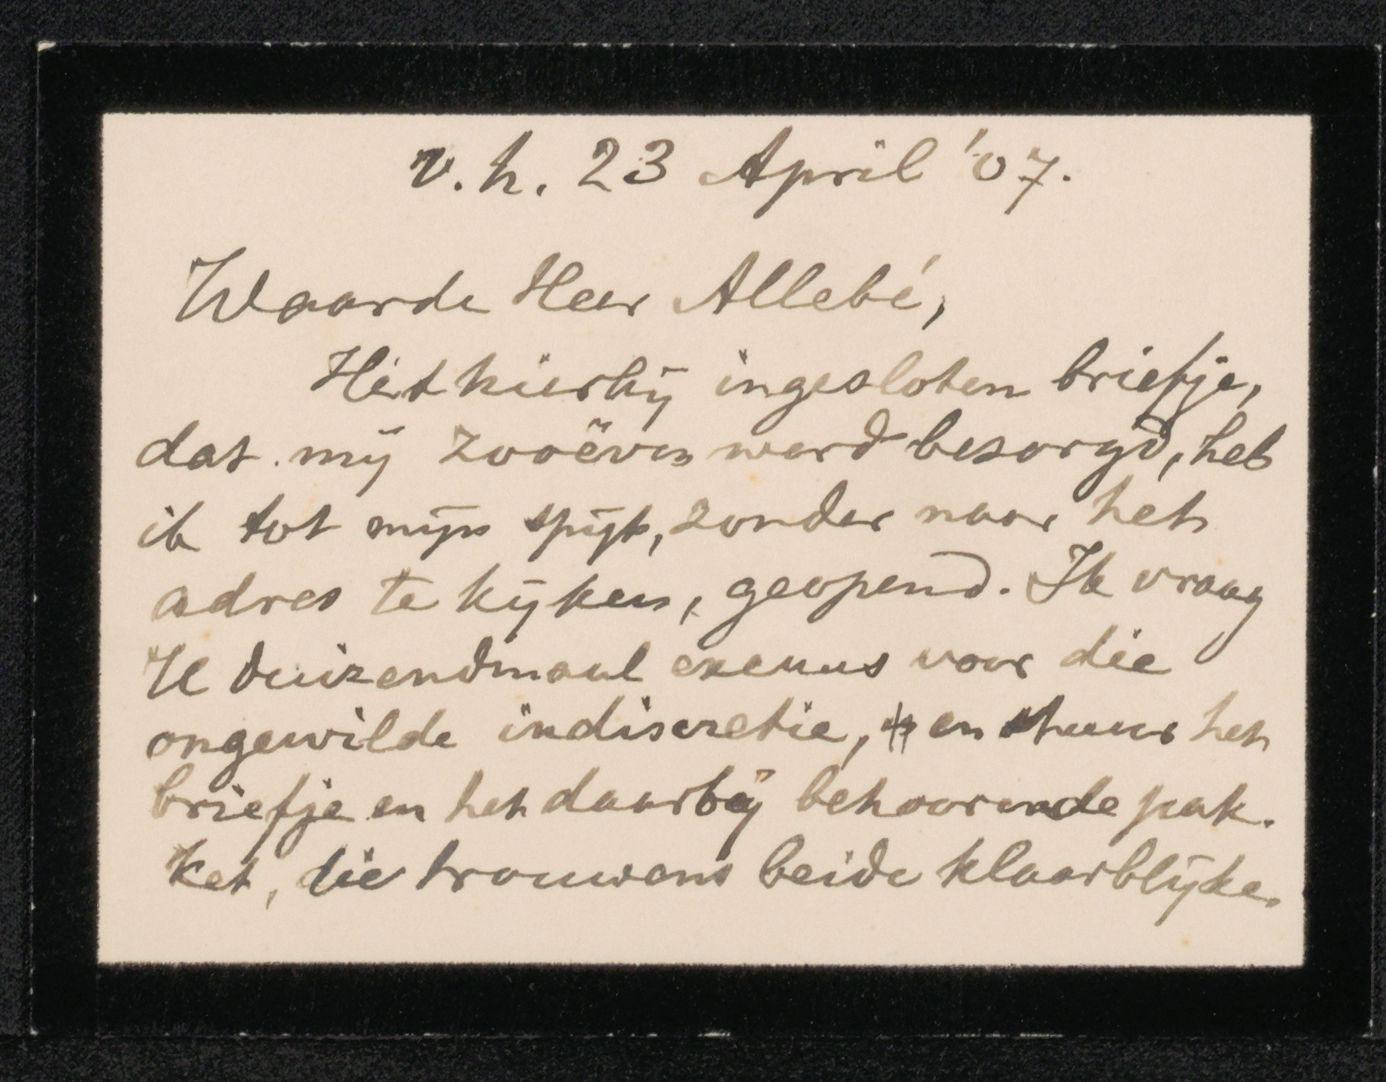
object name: letter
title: Brief aan August Allebé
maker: jérôme alexander sillem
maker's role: politician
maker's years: 1840-1912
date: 1907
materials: cardboard, ink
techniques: pen, writing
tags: print maker, draughtsman, august allebé